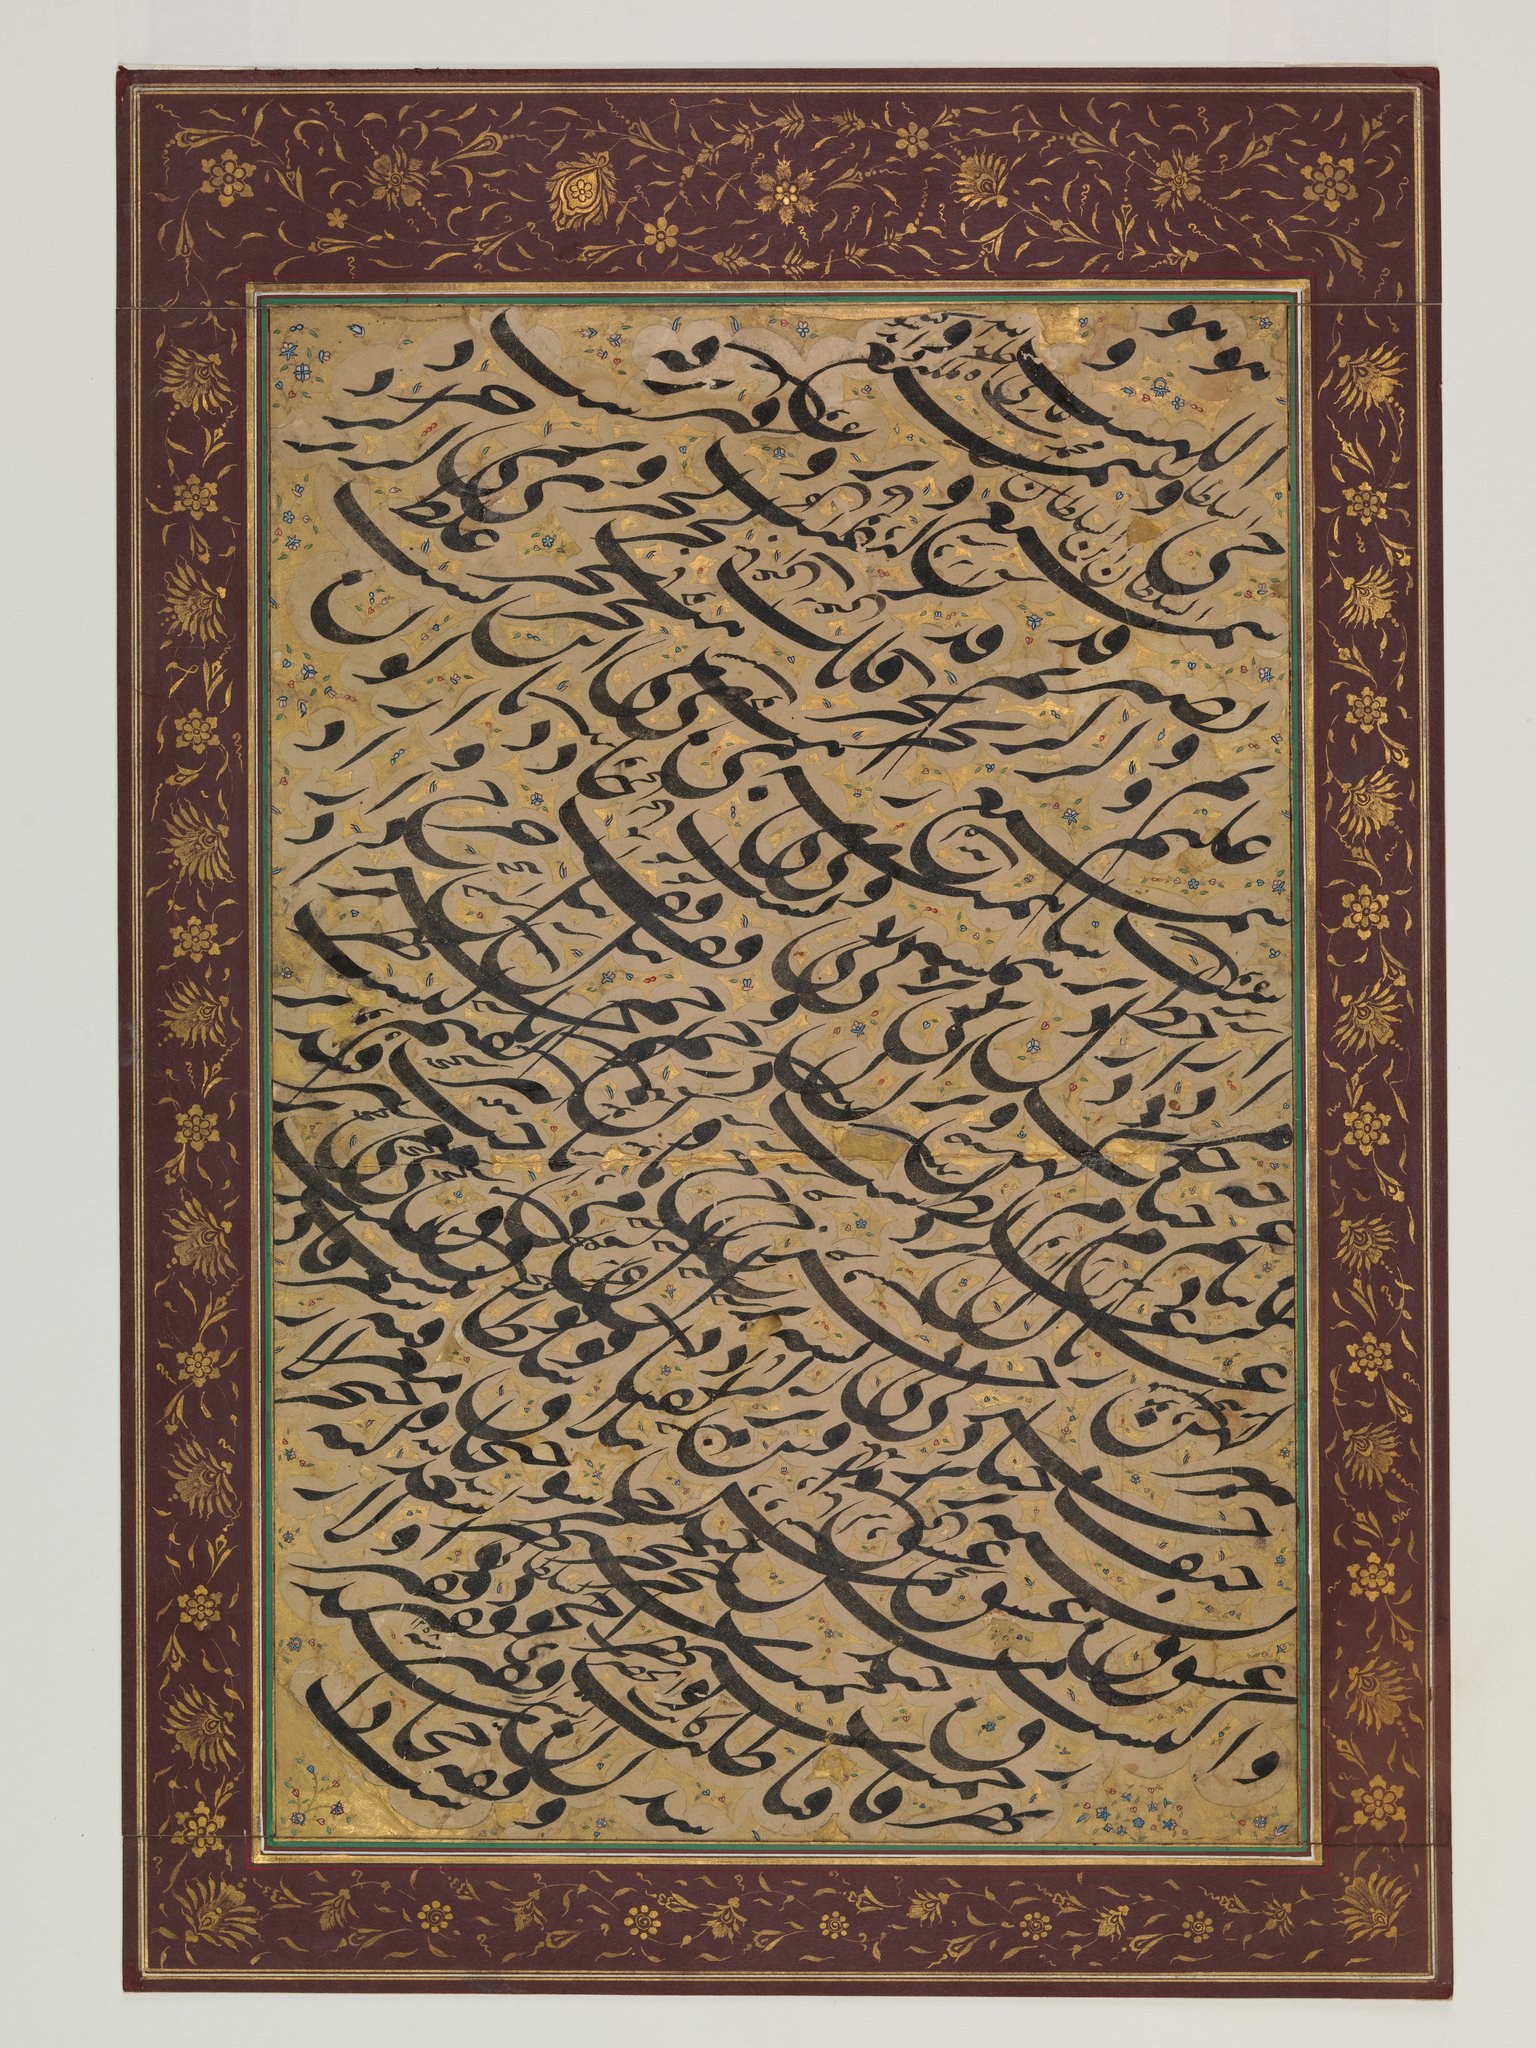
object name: non illustrated album leaf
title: Album Leaf with Calligraphic Exercise (siyah mashq)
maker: asadullah shirazi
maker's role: calligrapher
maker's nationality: iranian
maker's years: 1805-1875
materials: gold, ink, paper, watercolor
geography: iran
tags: calligraphy